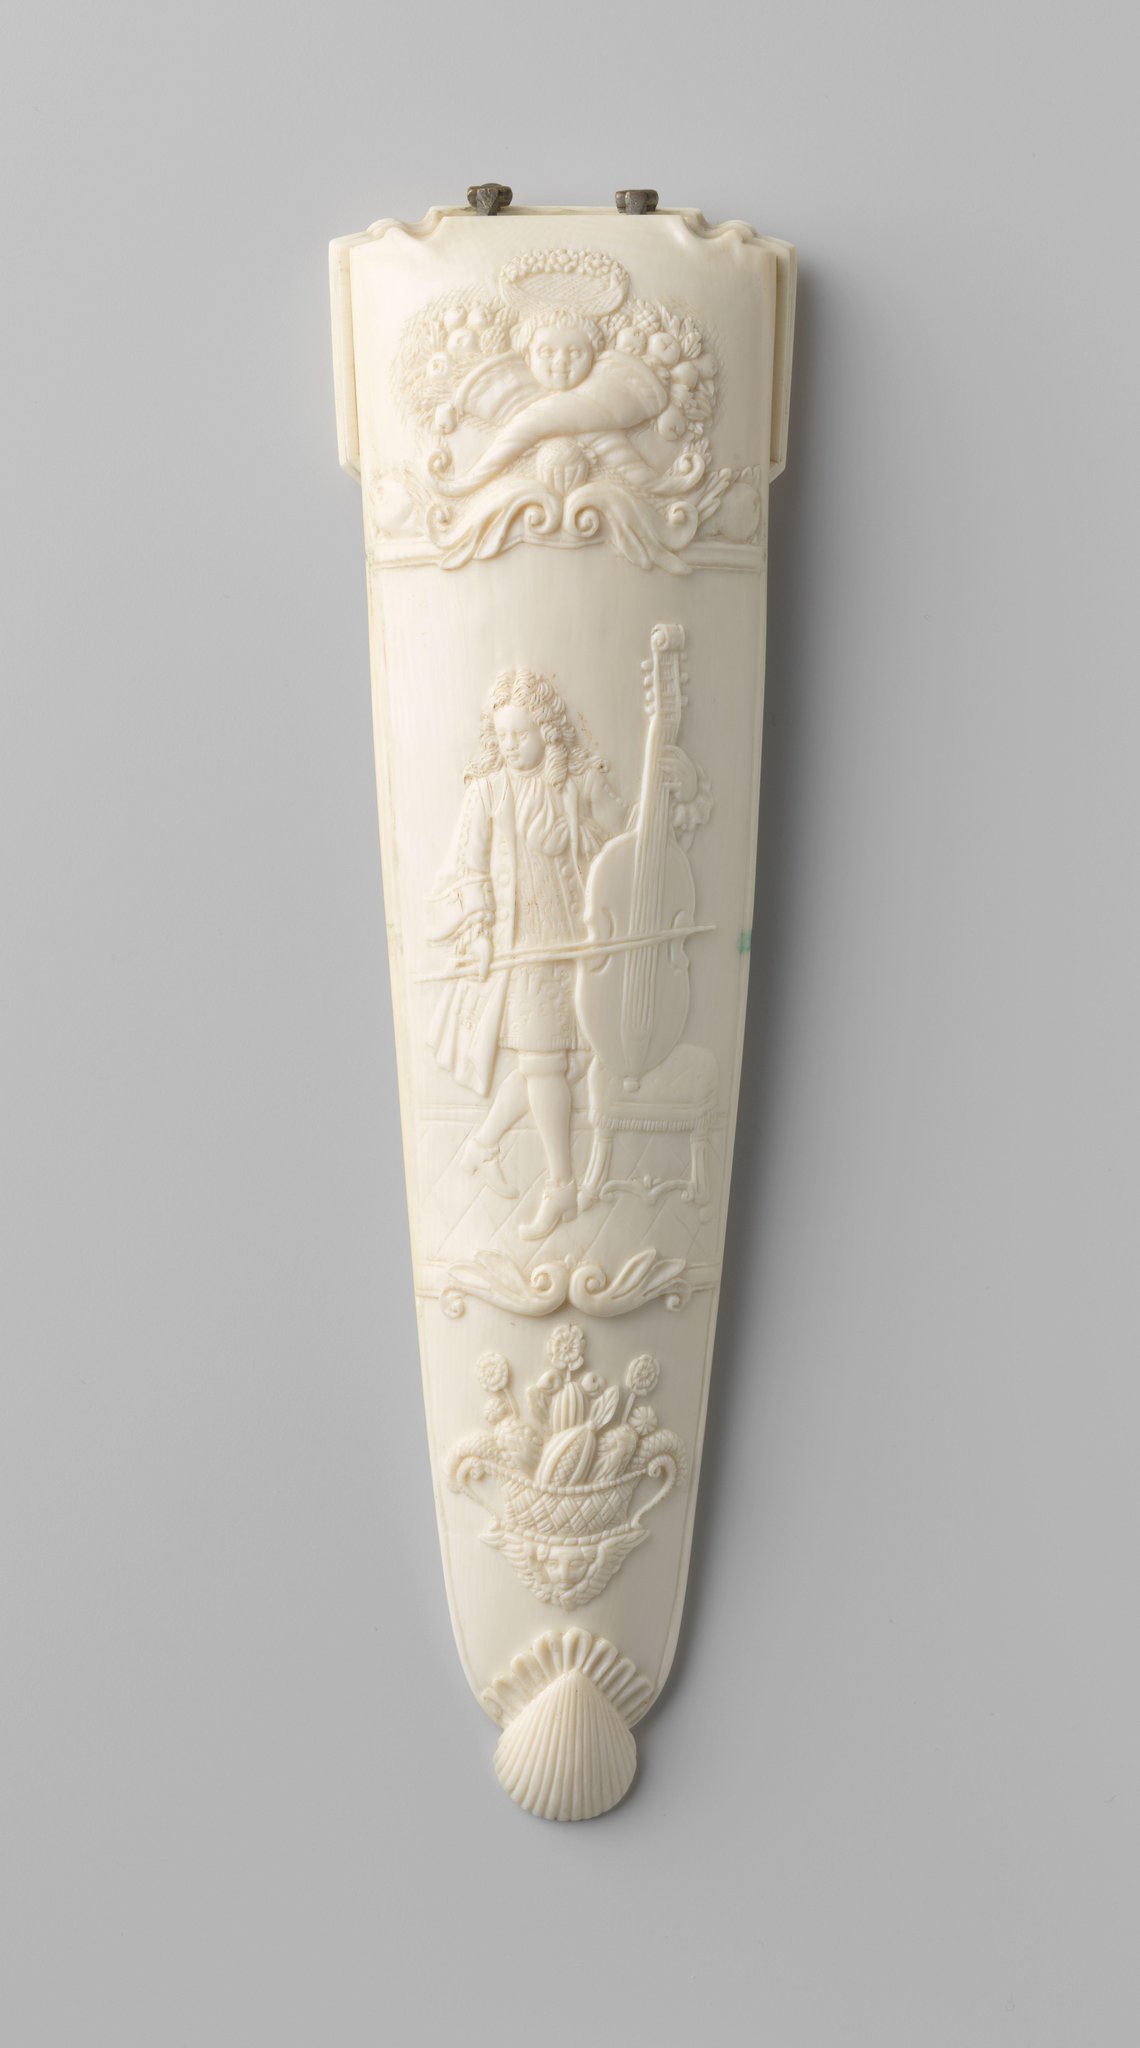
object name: grater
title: Viola da gamba spelende heer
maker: Anonymous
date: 1700-1750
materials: ivory, metal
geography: netherlands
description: Tabaksrasp met rug en doosje van ivoor. Op de rug is in reliëf een heer voorgesteld die een viola da gamba bespeelt; daarboven hoornen van overvloed, van onder een mand bloemen. Op het deksel van het doosje een schaal vruchten. De rasp is aan onderzijde versierd met een schelpvorm.